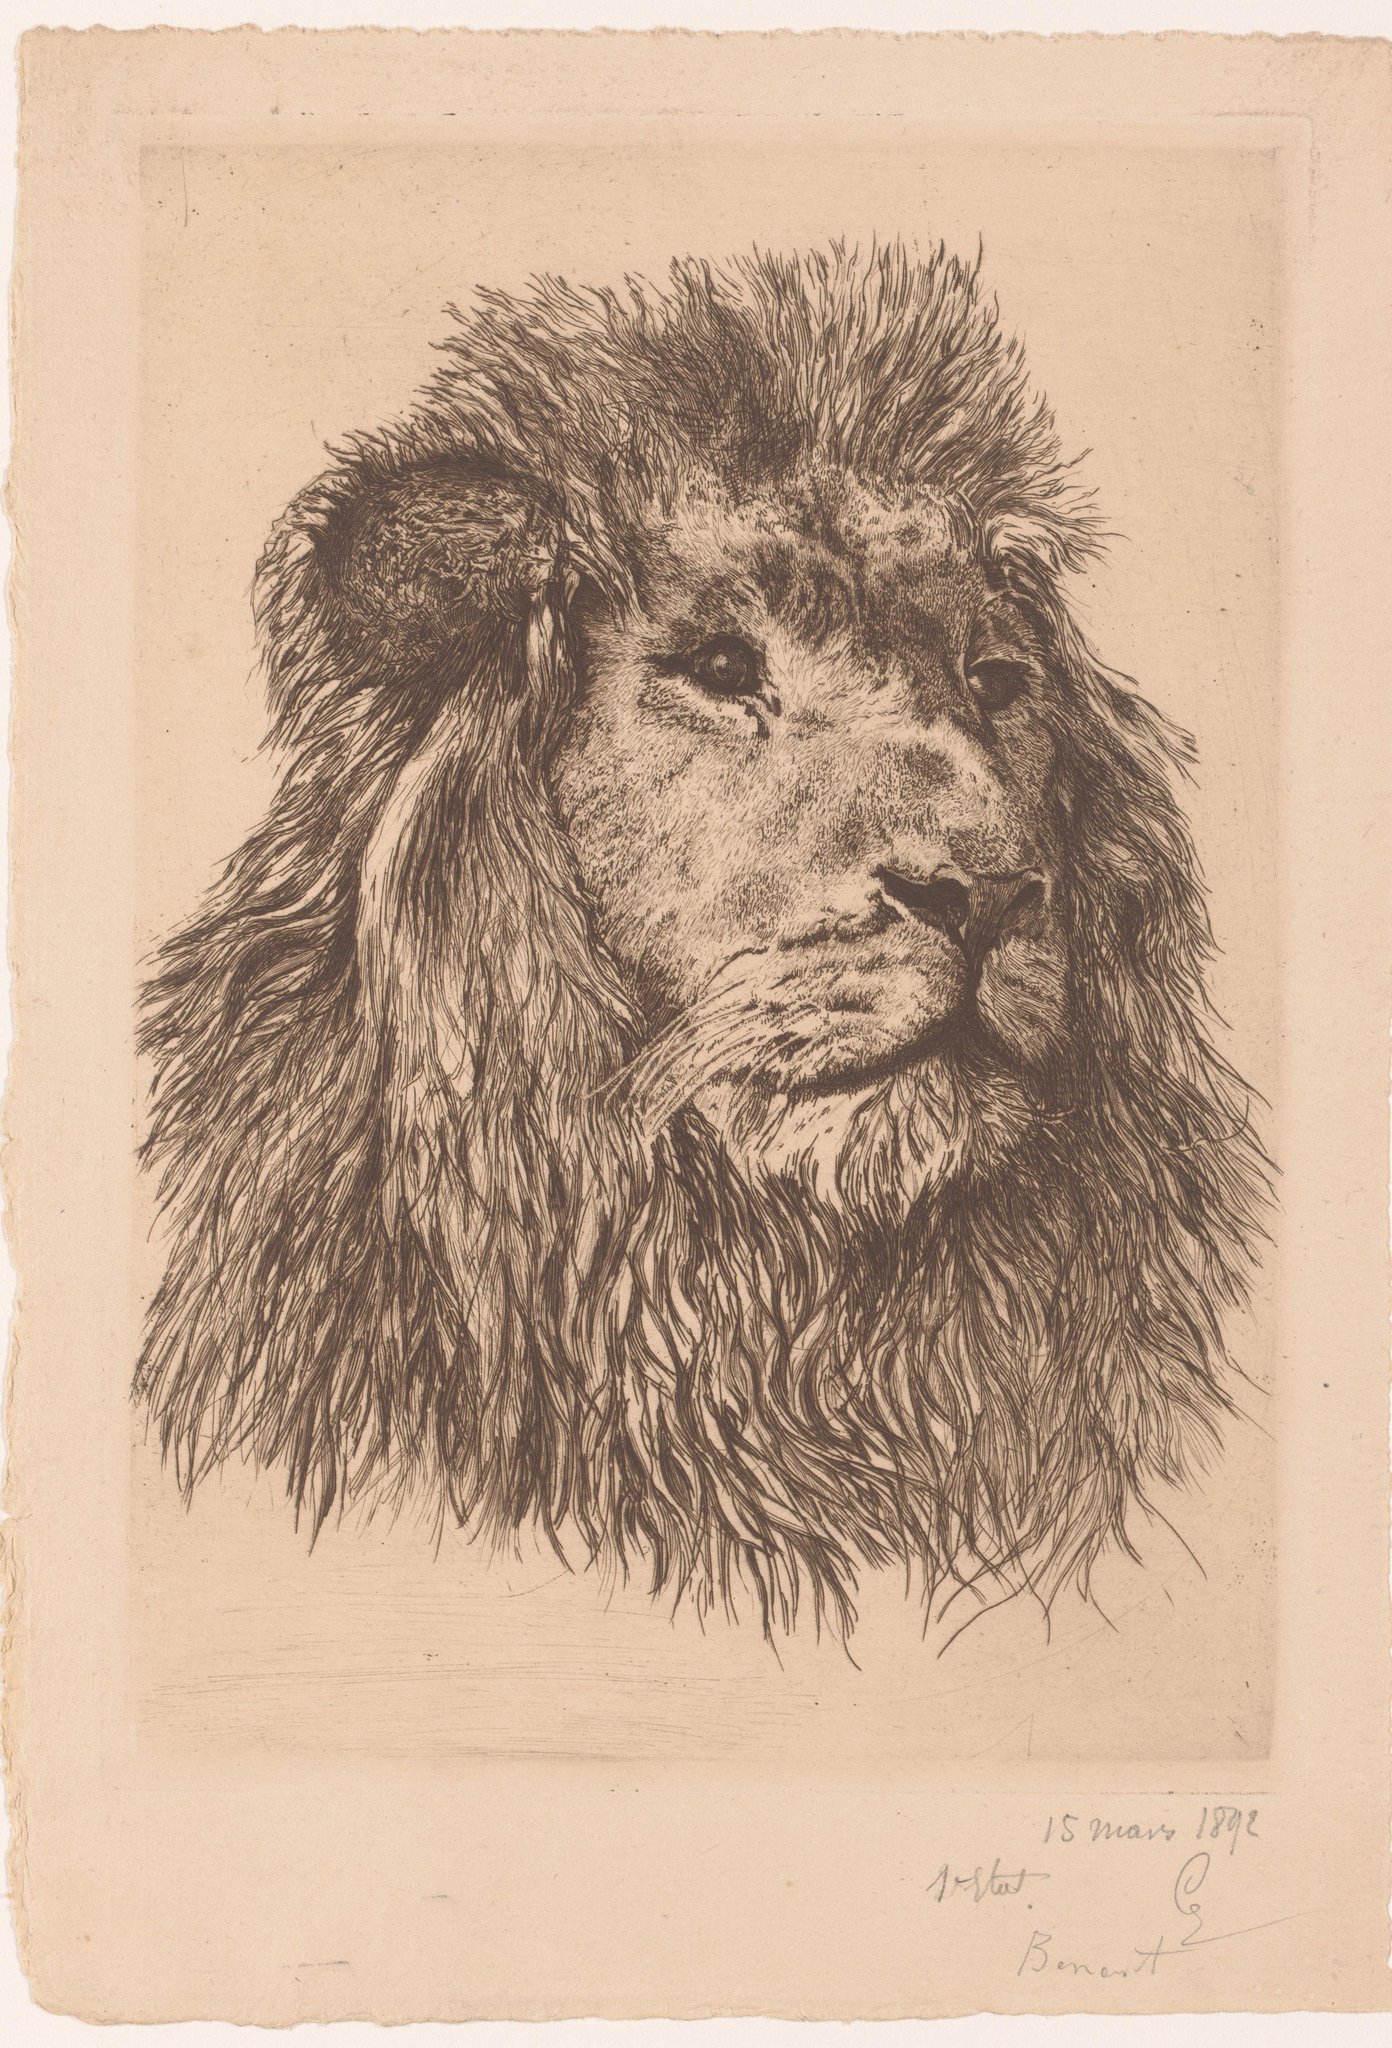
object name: print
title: Leeuwenkop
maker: clément benoit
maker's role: draughtsman, painter, print maker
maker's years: 1866-1953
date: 1892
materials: paper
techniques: etching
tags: beasts of prey, predatory animals: lion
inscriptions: collector's mark: Lugt 2228